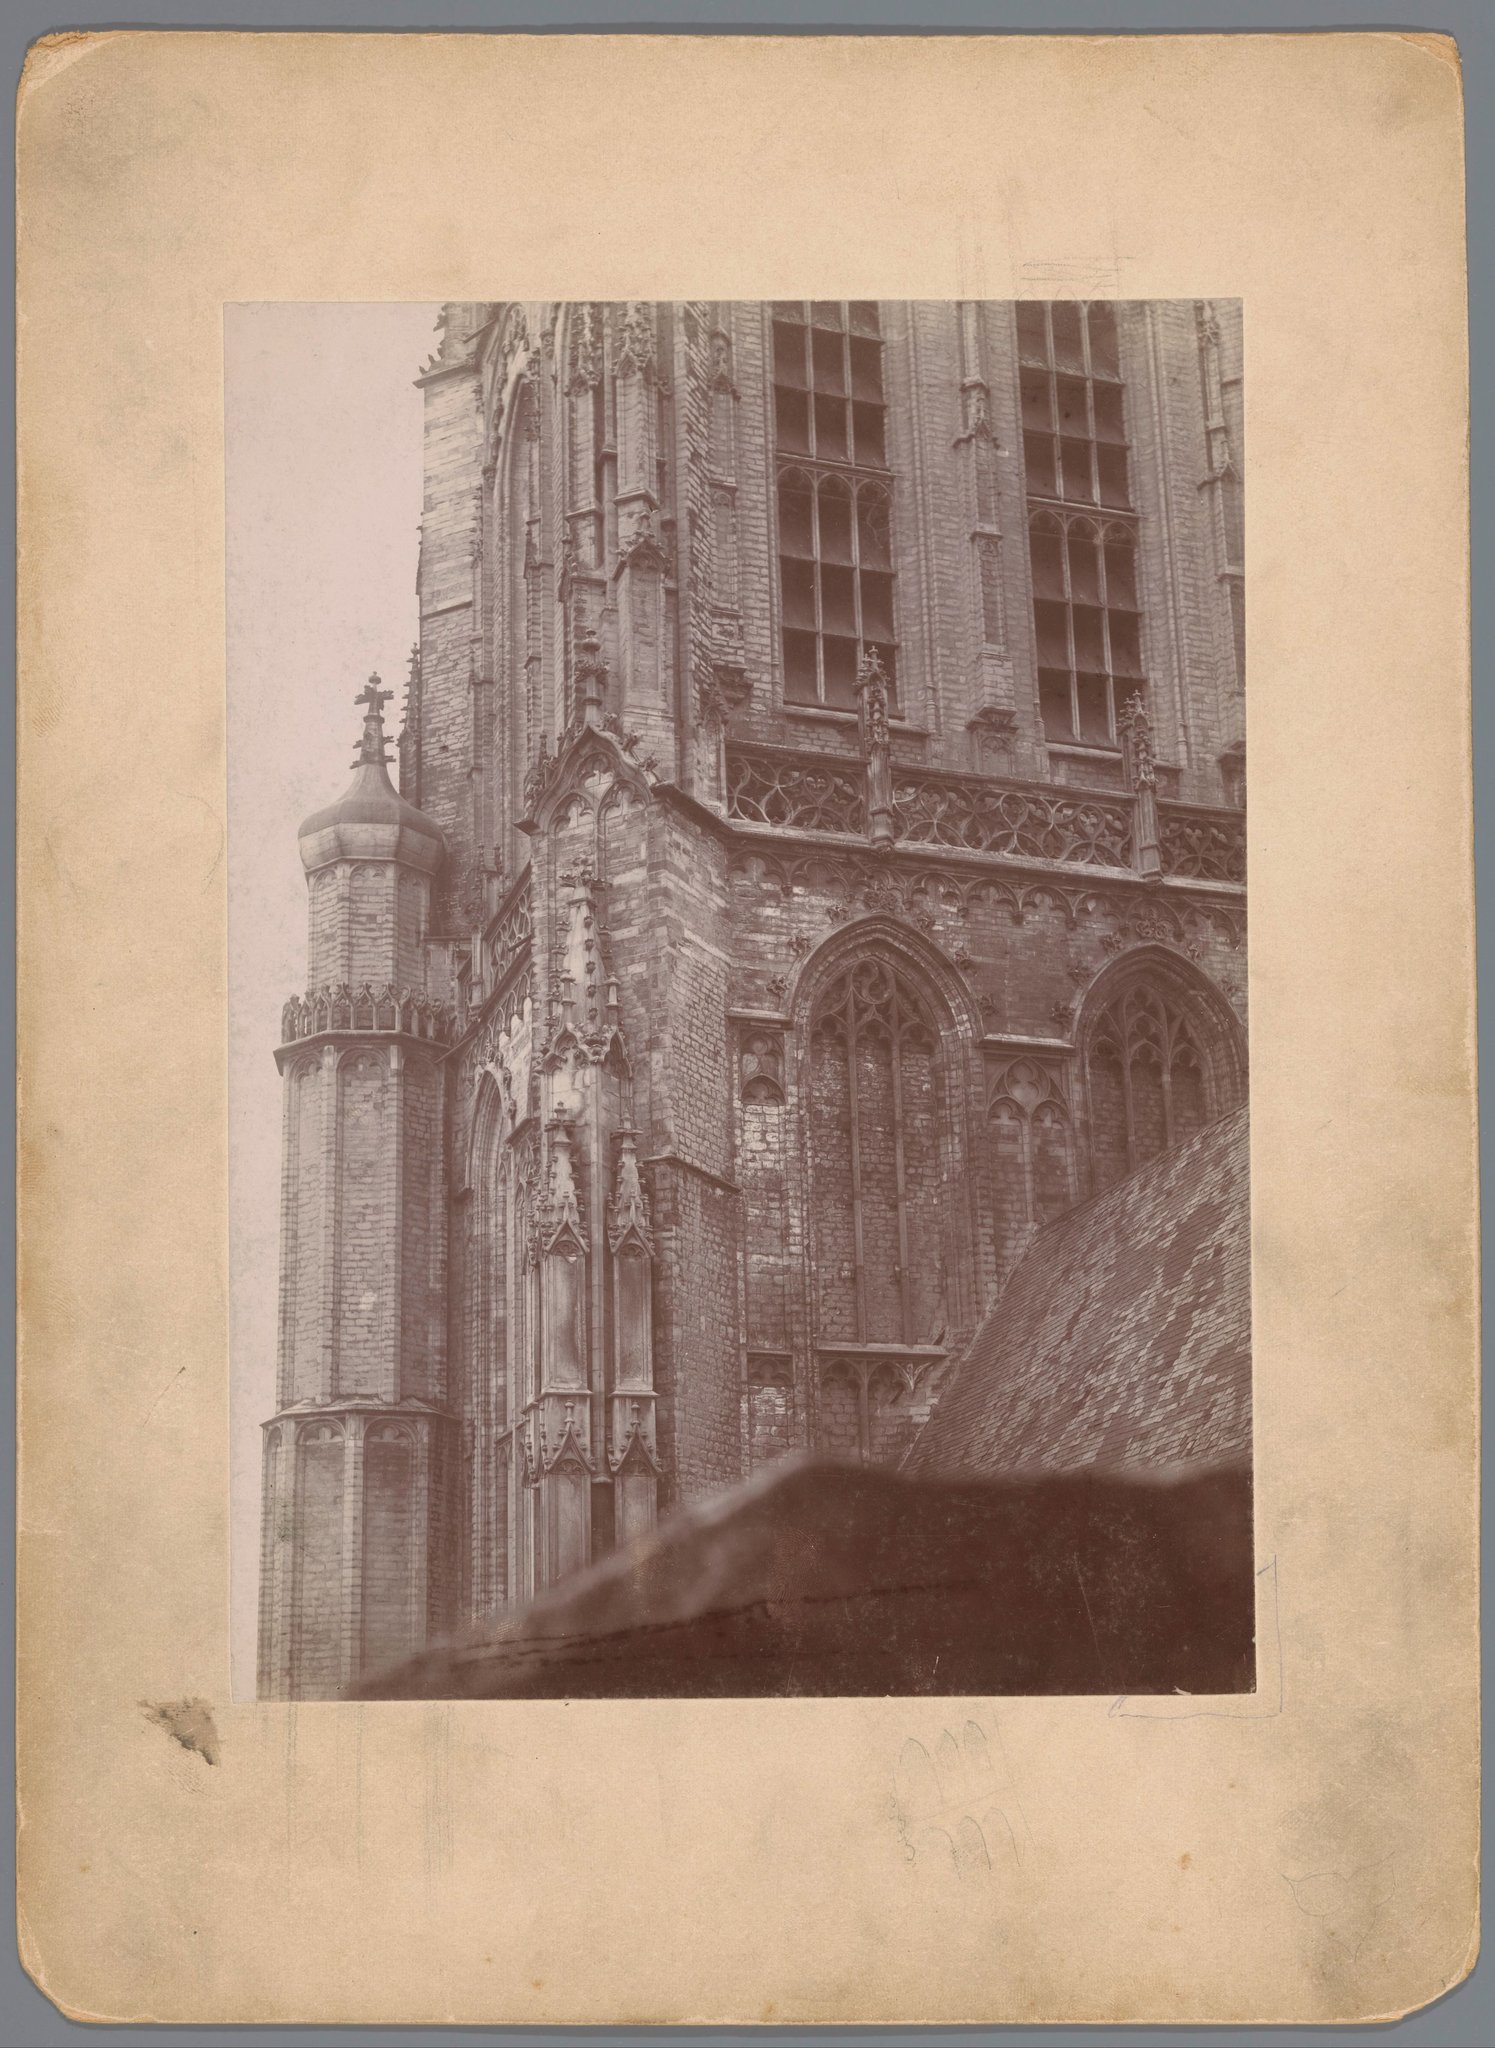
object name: photograph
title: Toren van de Onze-Lieve-Vrouwekerk te Breda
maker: Anonymous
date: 1875-1900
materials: cardboard, photographic support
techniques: daylight paper print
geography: breda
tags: roman catholic church, parts of church exterior and annexes: tower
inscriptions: collector's mark: Lugt 3937, annotation, annotation, inscription: ‘Toren v/d R K kerk te Breda’